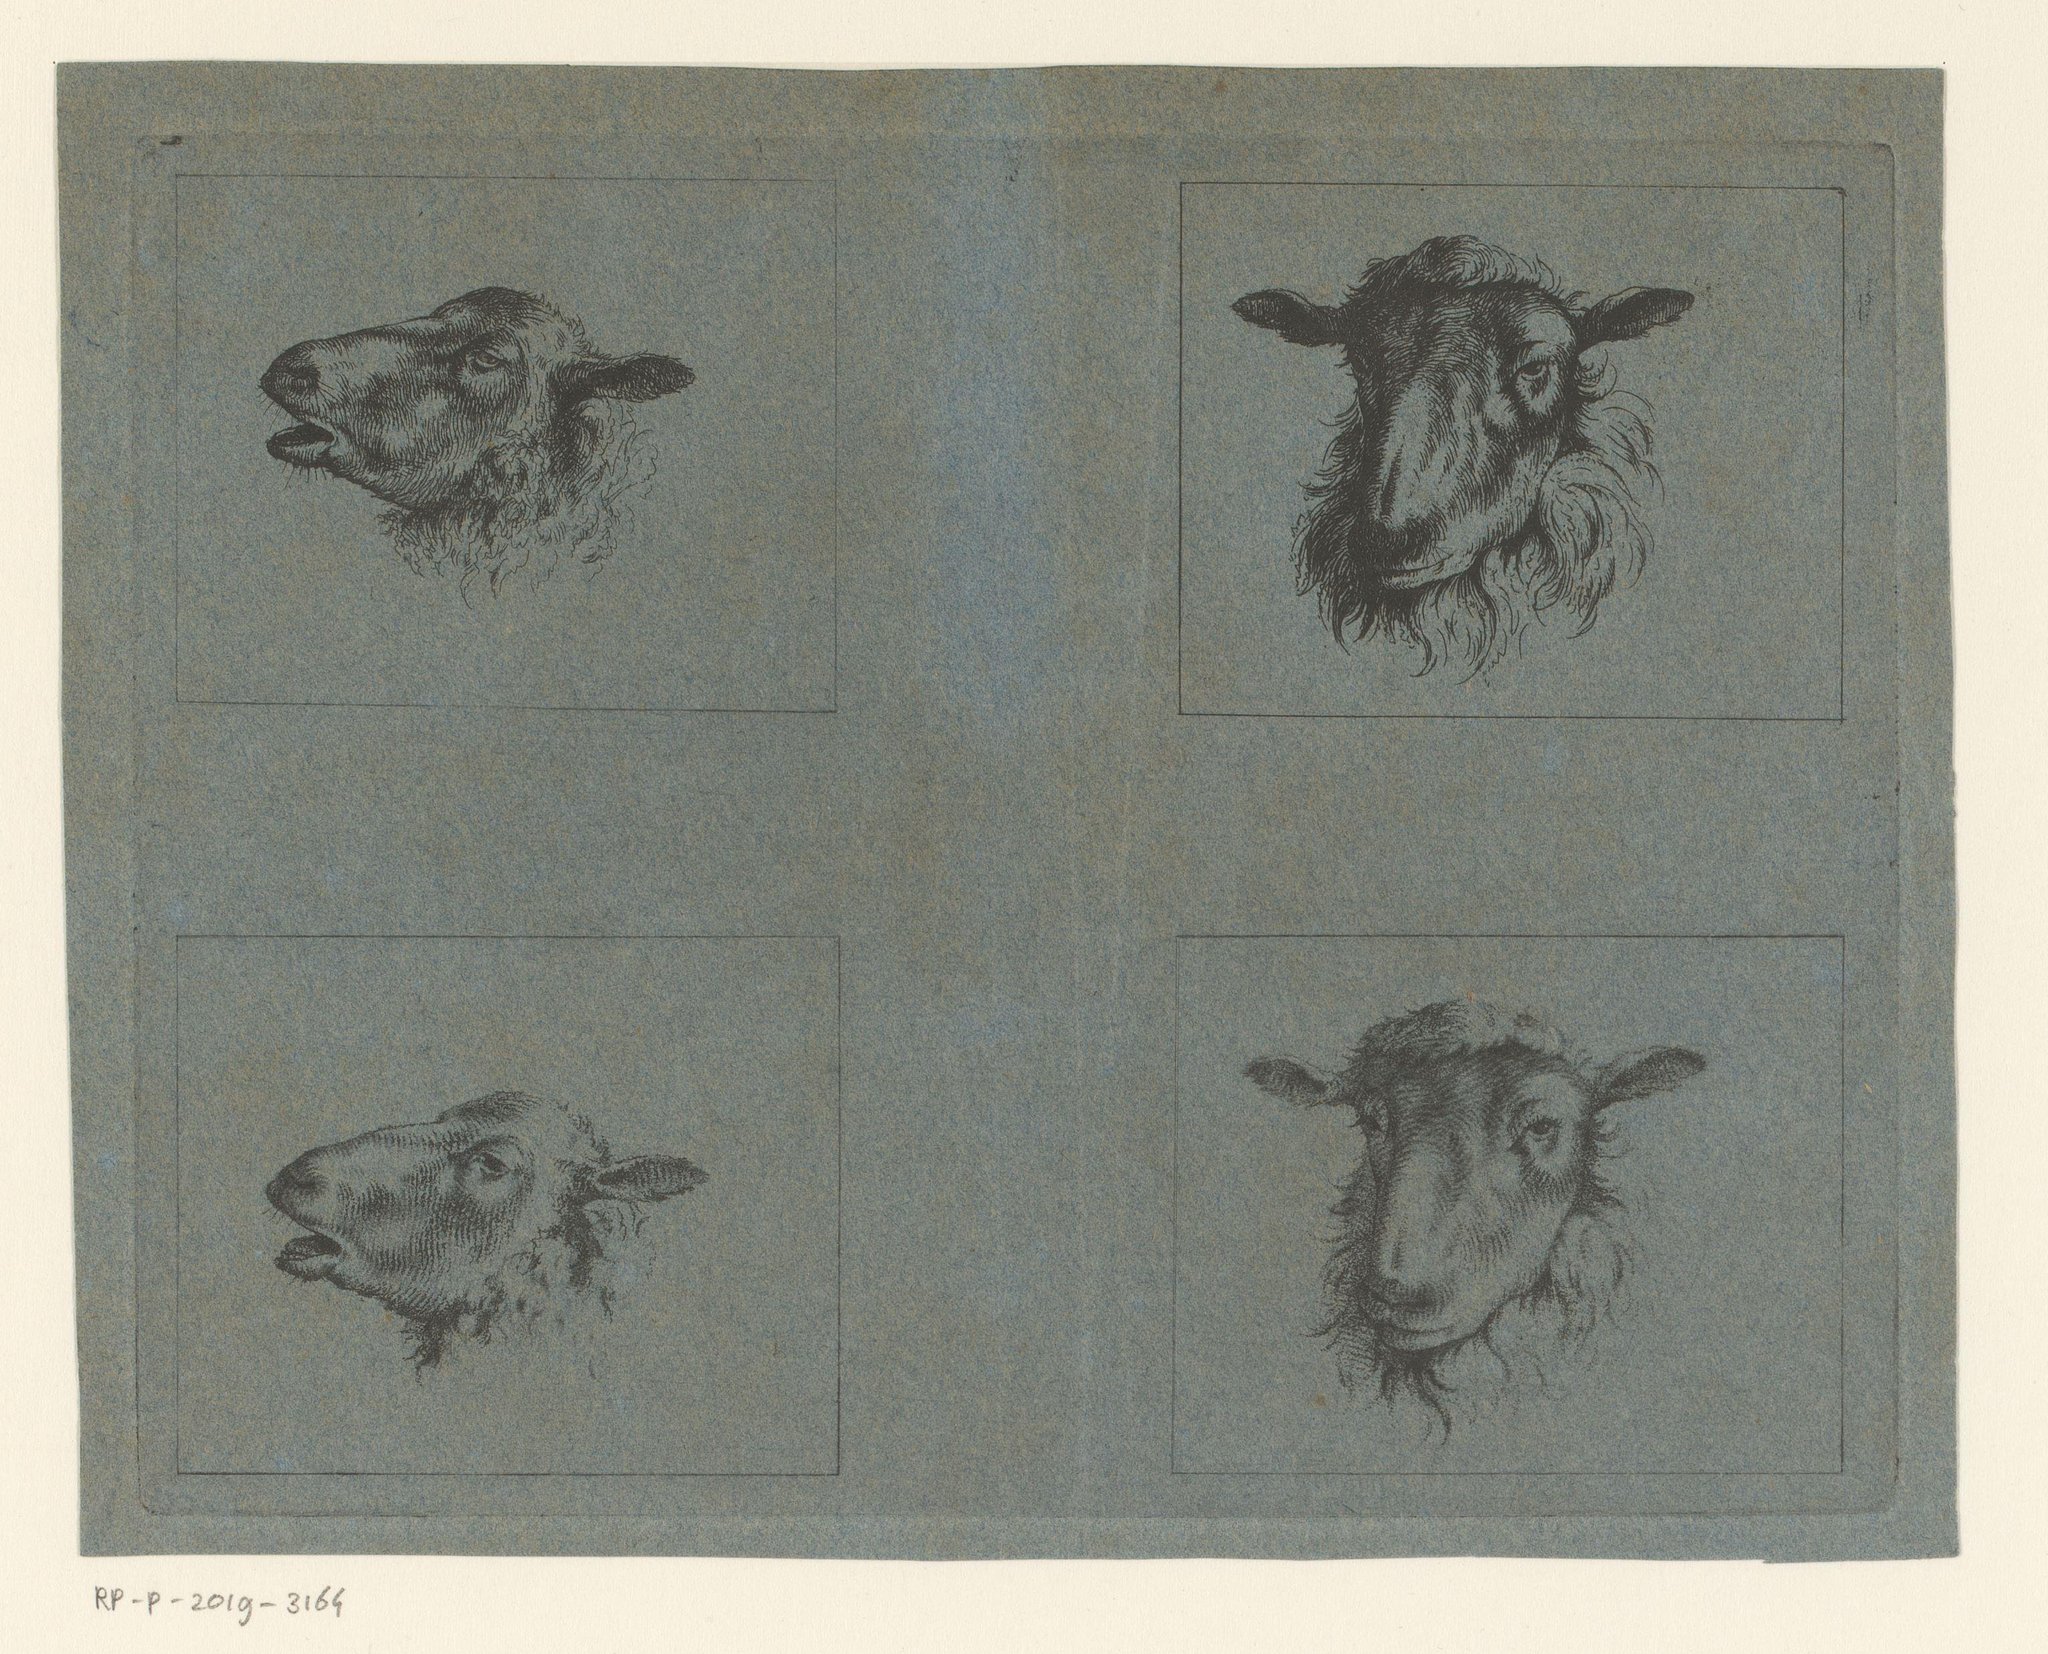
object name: print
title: Vier schapenkoppen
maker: johannes janson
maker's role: draughtsman, painter, print maker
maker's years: 1729-1784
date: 1739-1784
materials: paper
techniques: etching, soft ground etching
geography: leiden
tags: sheep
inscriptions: collector's mark: Lugt 2228